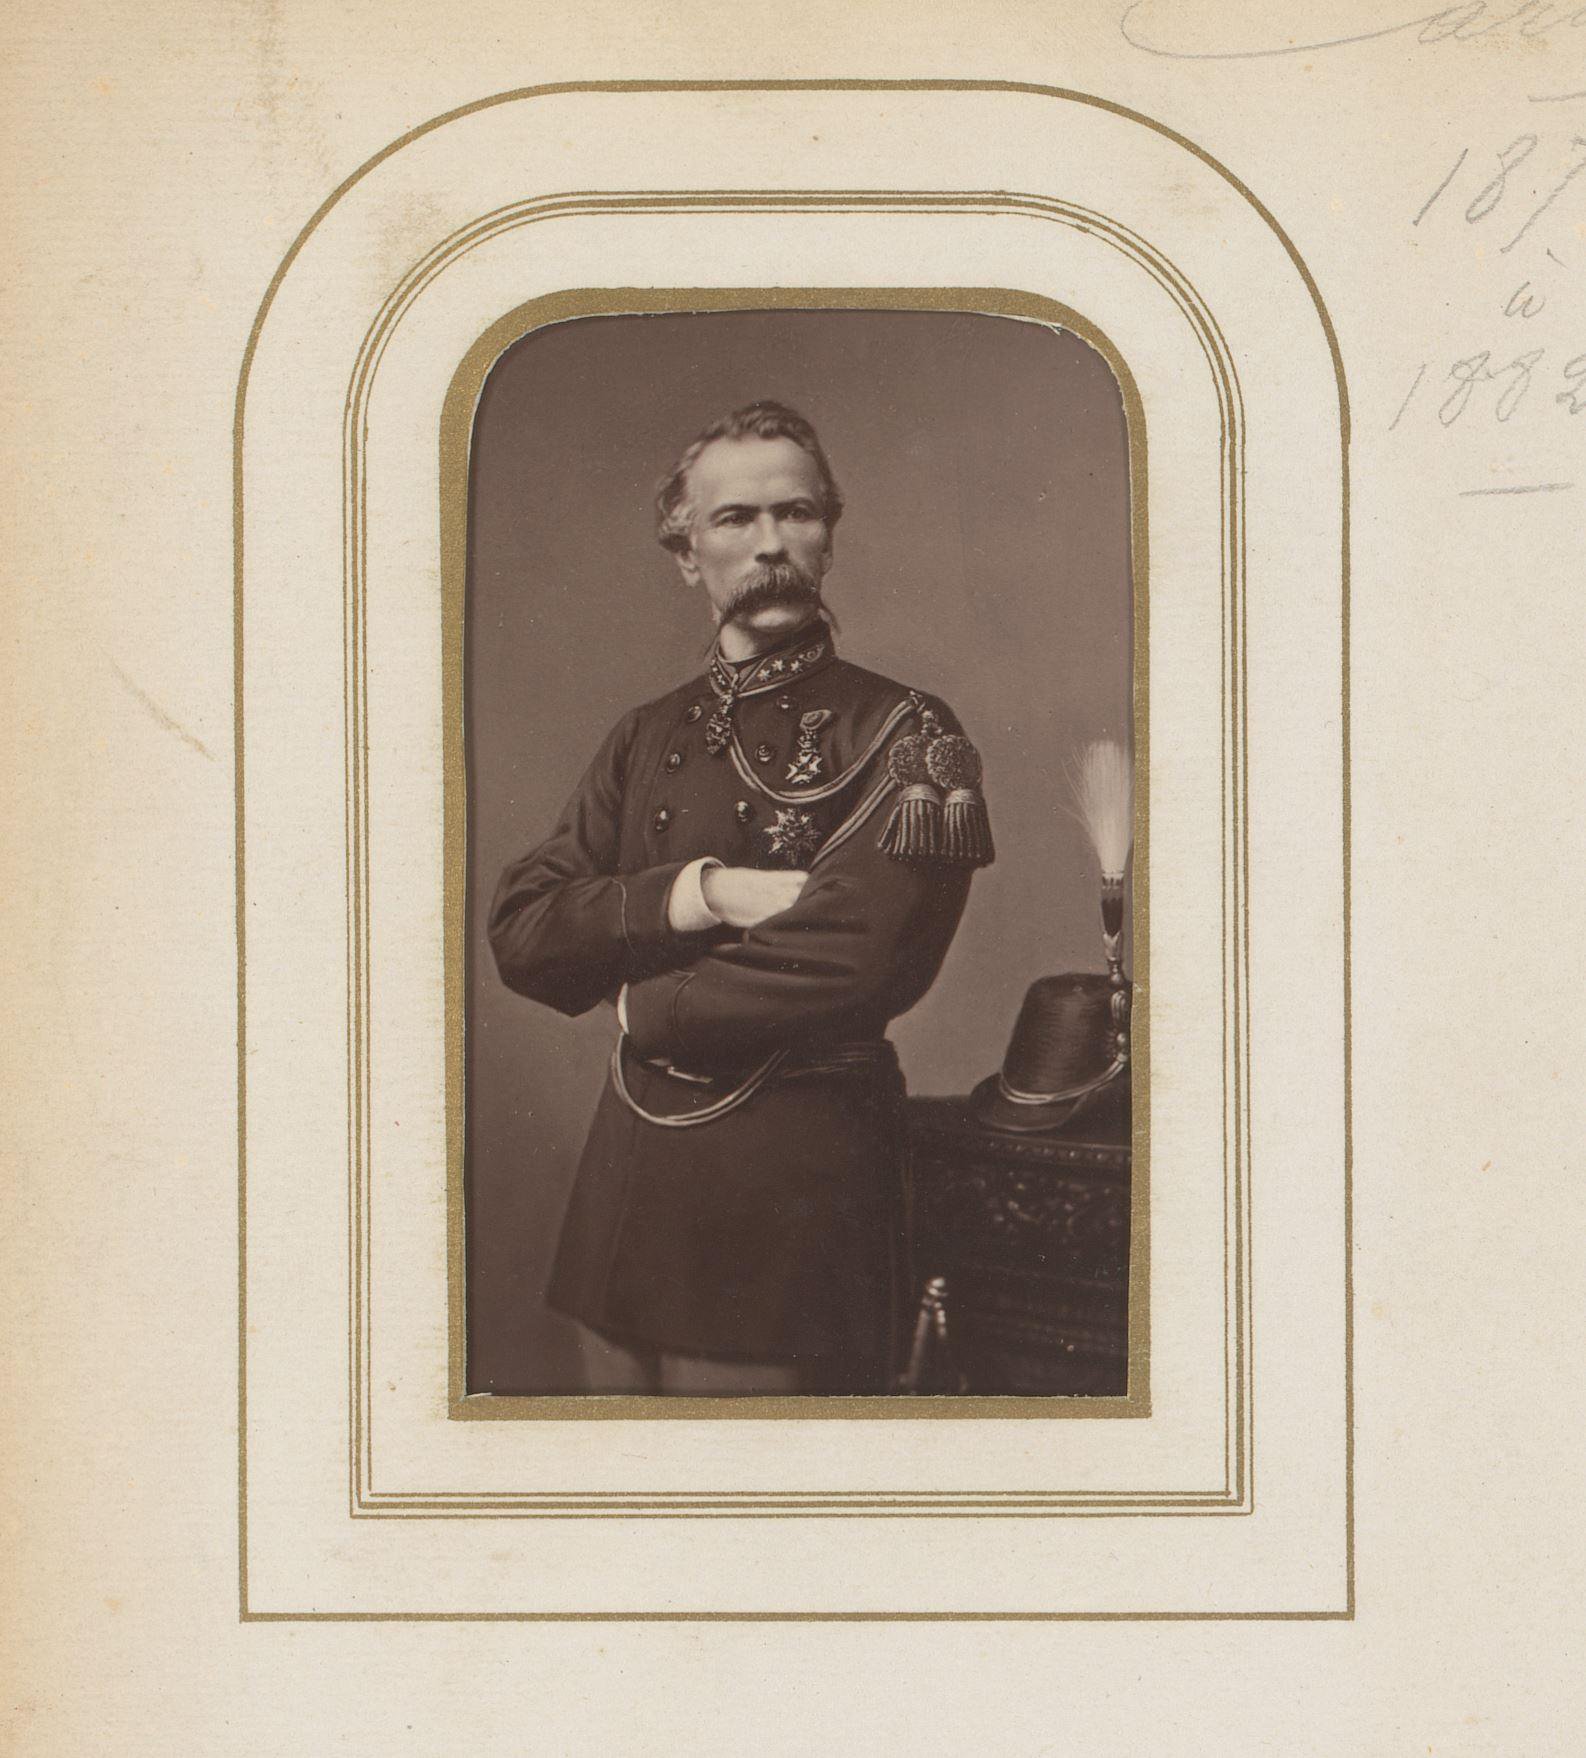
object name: photograph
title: Portret van een man in uniform met snor, vermoedelijke Alexandre Lemoine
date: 1868-1890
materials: cardboard, paper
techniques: carbon print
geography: brussels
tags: alexandre lemoine, moustache, historical persons, hacking and thrusting weapons: sword, (military) uniforms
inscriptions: inscription: ‘procédé inaltérable/ photographie au charbon/ exposition universelle/ Paris 1878/ Géruzet Frères/ Photographes de S.M. la Reine des Belges/ 27b Rue de l'Ecuyer/ Bruxelles’, annotation: ‘Carabiniers/ 1878 à 1882’